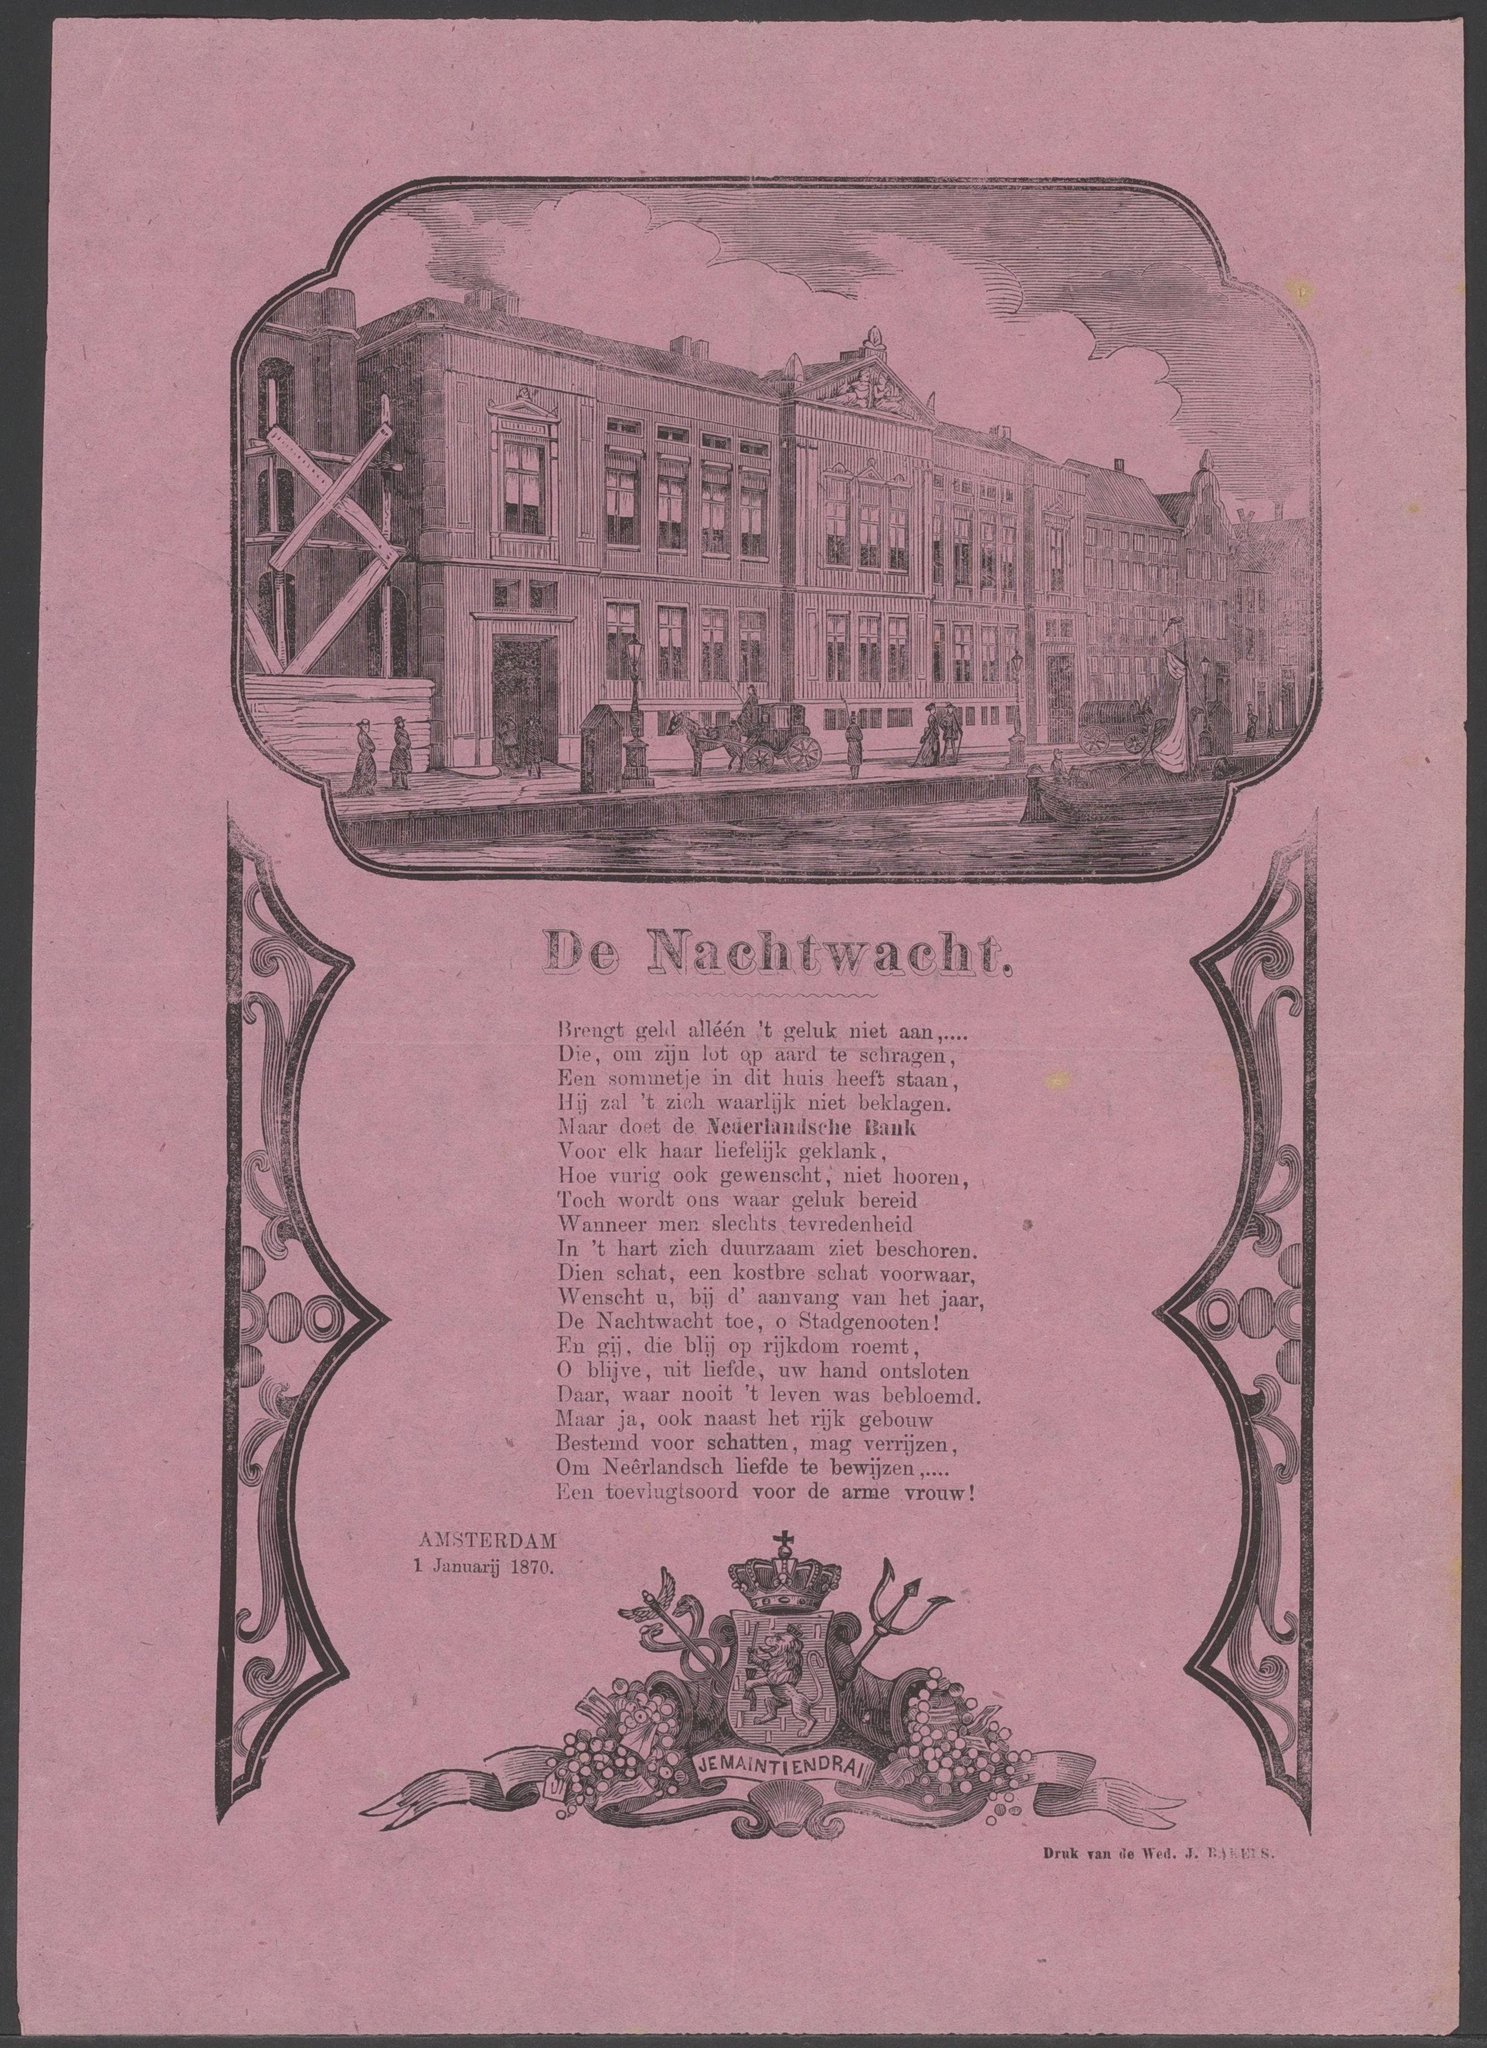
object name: print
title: Nieuwjaarswens van de Amsterdamse nachtwacht voor het jaar 1870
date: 1869-1870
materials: paper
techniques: letterpress printing, engraving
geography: amsterdam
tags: night patrol, coat of arms (as symbol of the state, etc.) (+ city; municipal), bank, amsterdam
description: Nieuwjaarswens van de Amsterdamse nachtwacht (ratelwacht) voor het jaar 1870. Onderaan een gedicht, bovenaan een gezicht op de Nederlandsche Bank, met het in 1868 voltooide nieuwe gebouw op de Oude Turfmarkt. Onderwerpsrubrieken binnen de Atlas Zeden en Gewoonten: Zeden en gewoonten in engeren zin, Volksleven, Volksbladen, Nieuwjaars- en Kerstwenschen, Amsterdam.